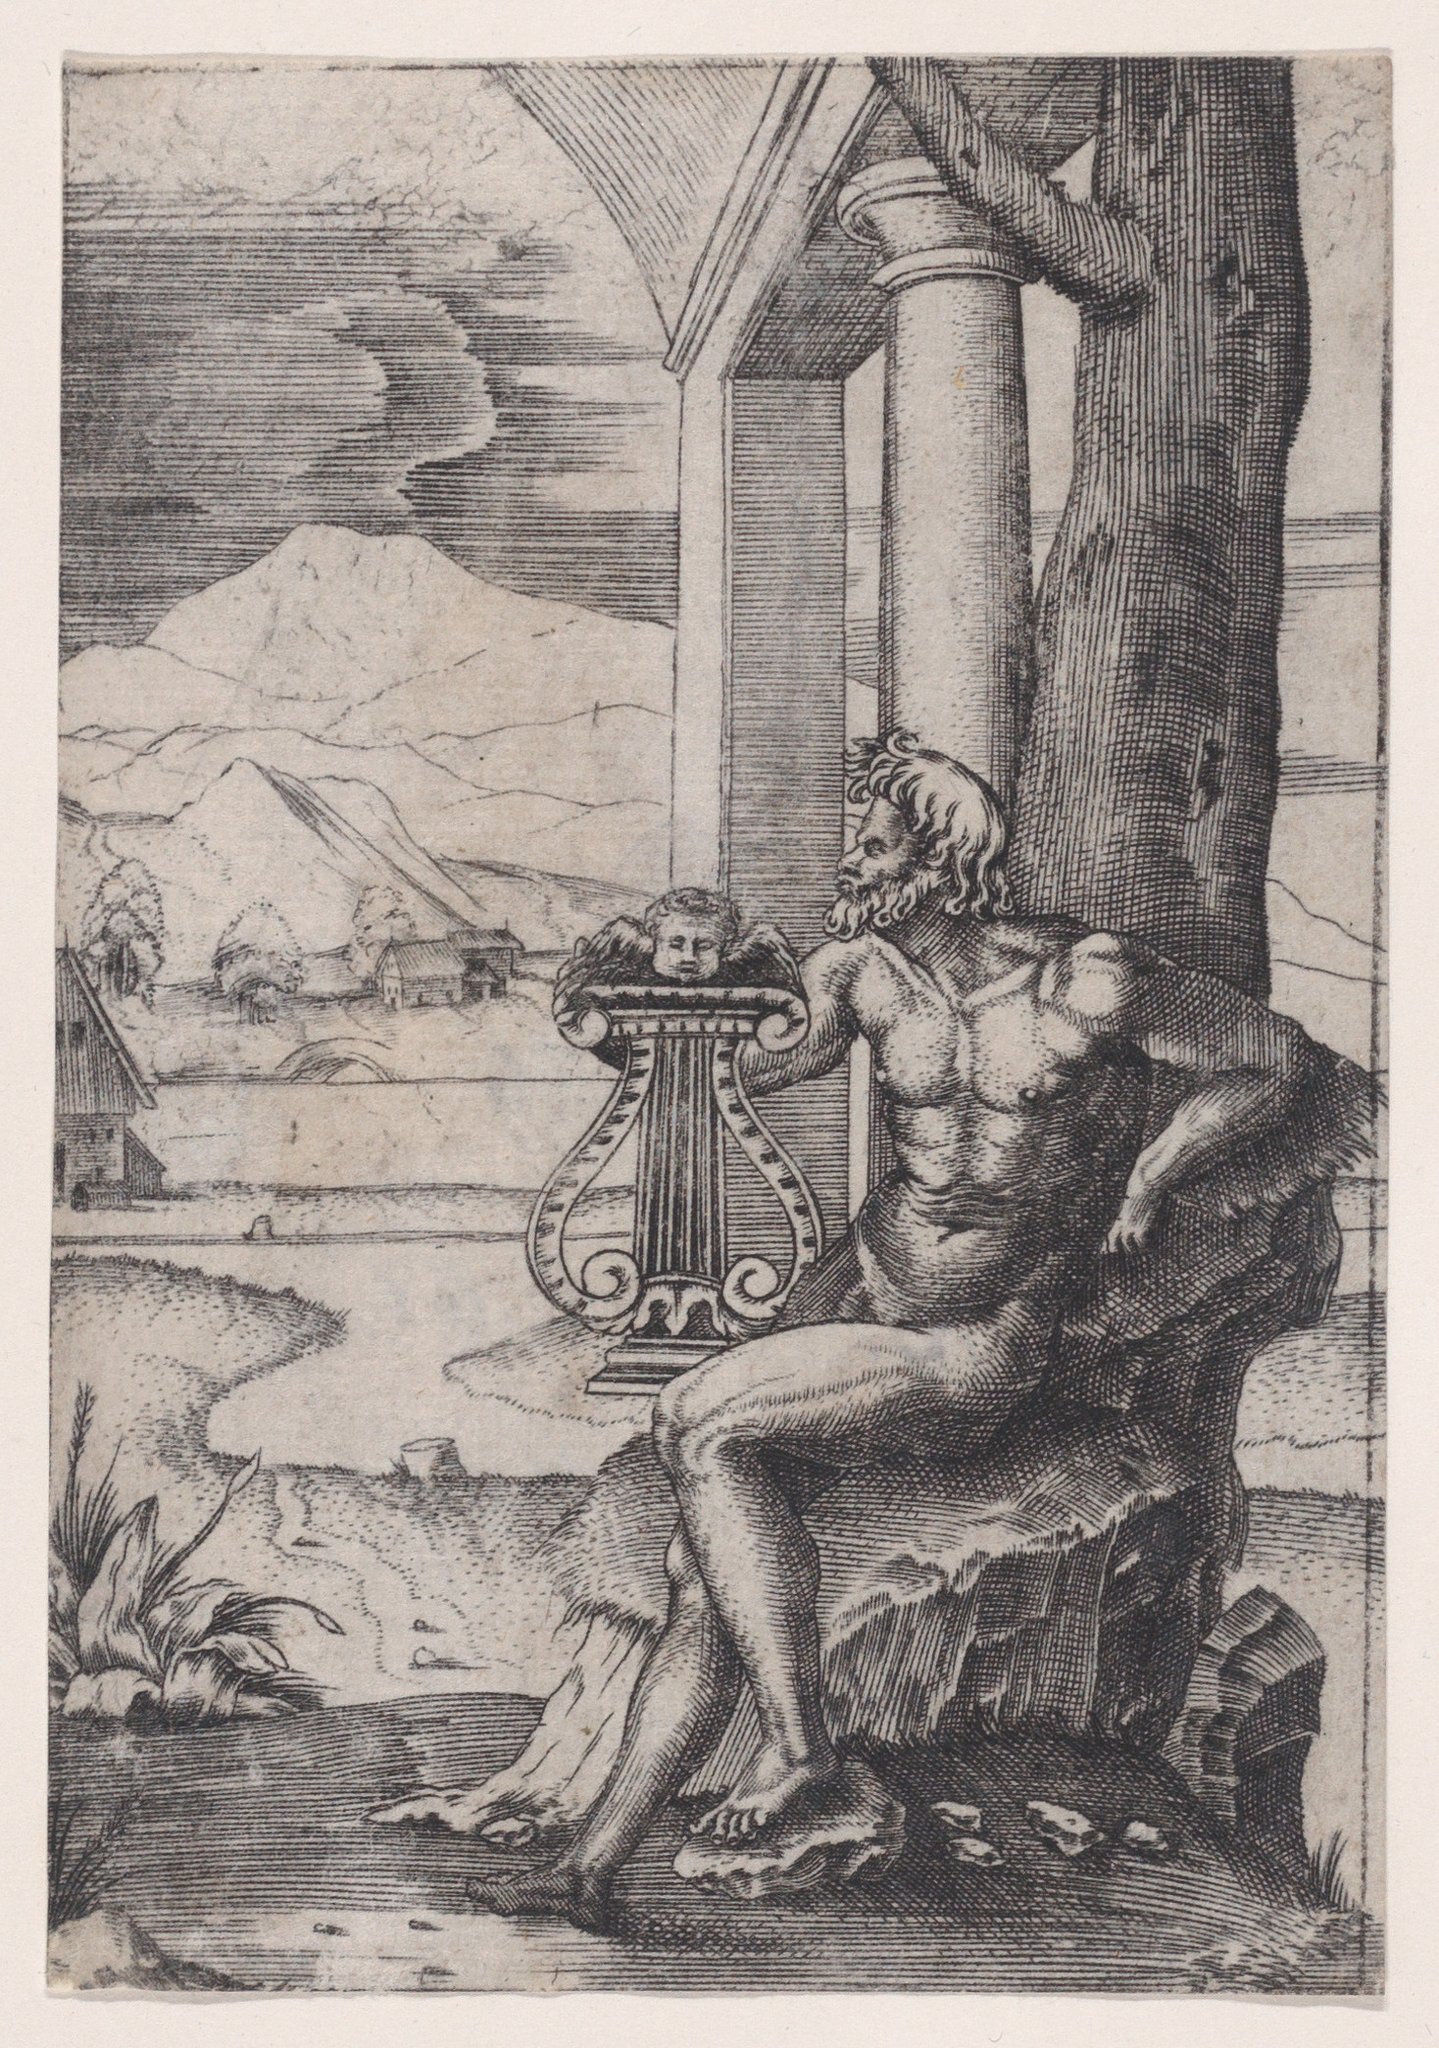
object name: print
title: Man with a Lyre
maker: agostino veneziano (agostino dei musi)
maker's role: artist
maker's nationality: italian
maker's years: 1490-1536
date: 1514-1536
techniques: engraving